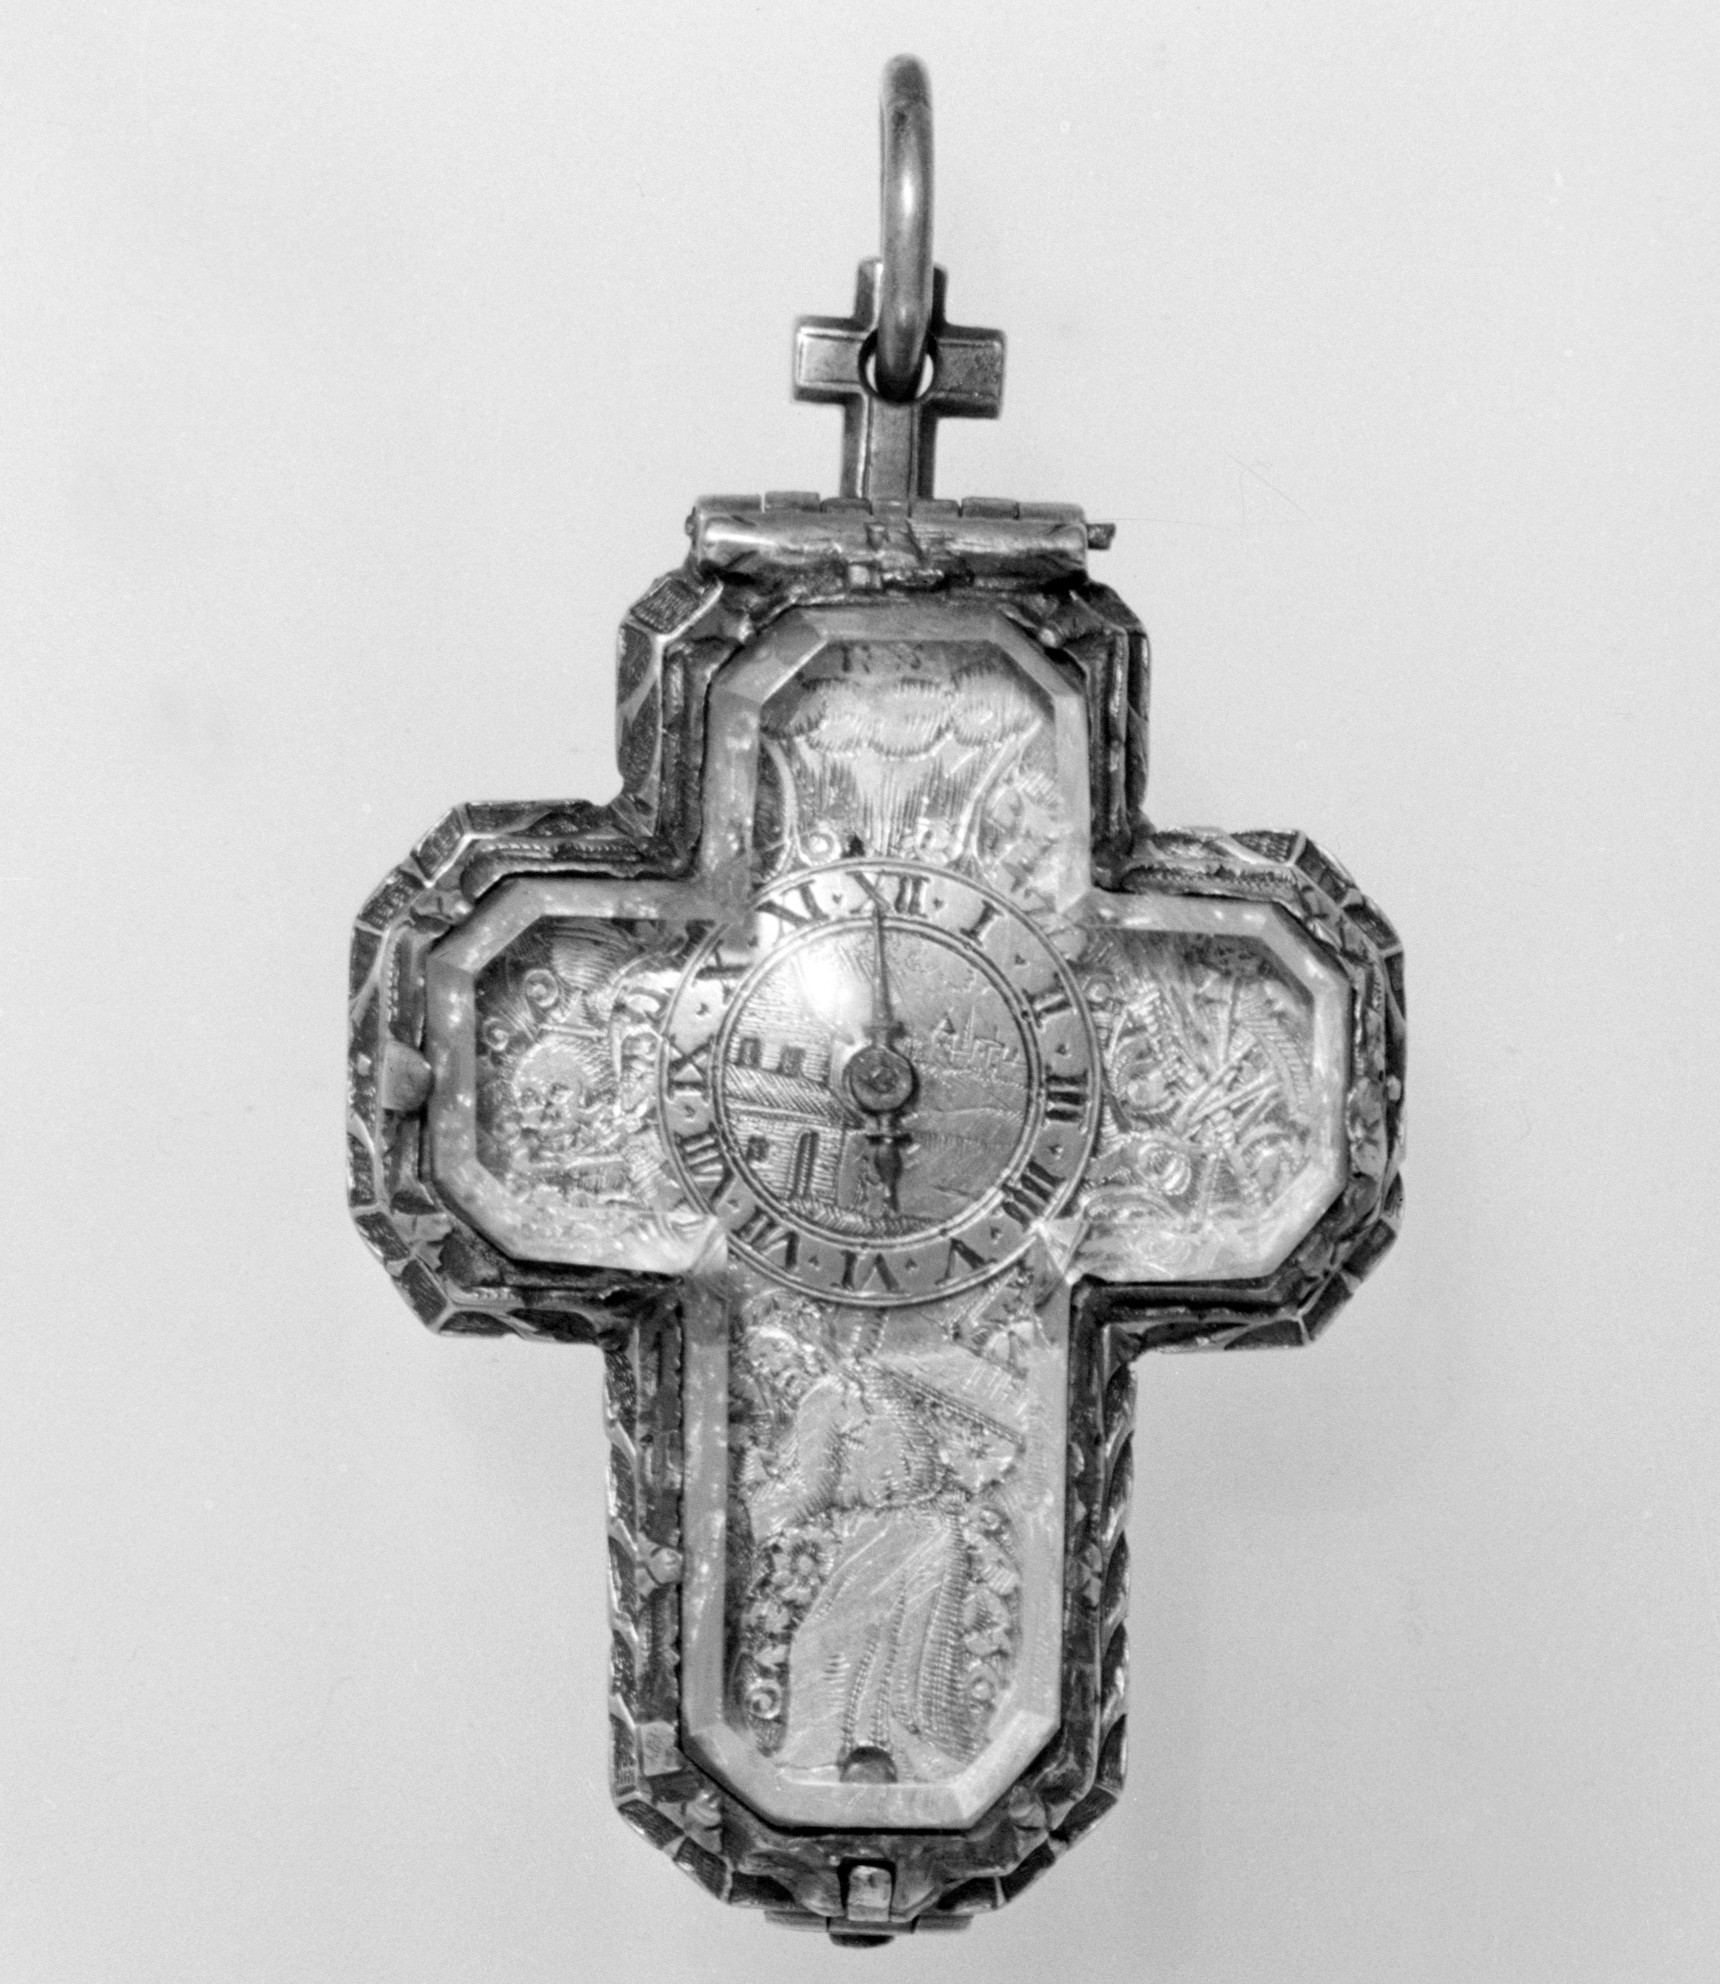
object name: watch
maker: jean cusin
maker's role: maker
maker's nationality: swiss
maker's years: 1585-1656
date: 1630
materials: metal, quartz, silver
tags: cross